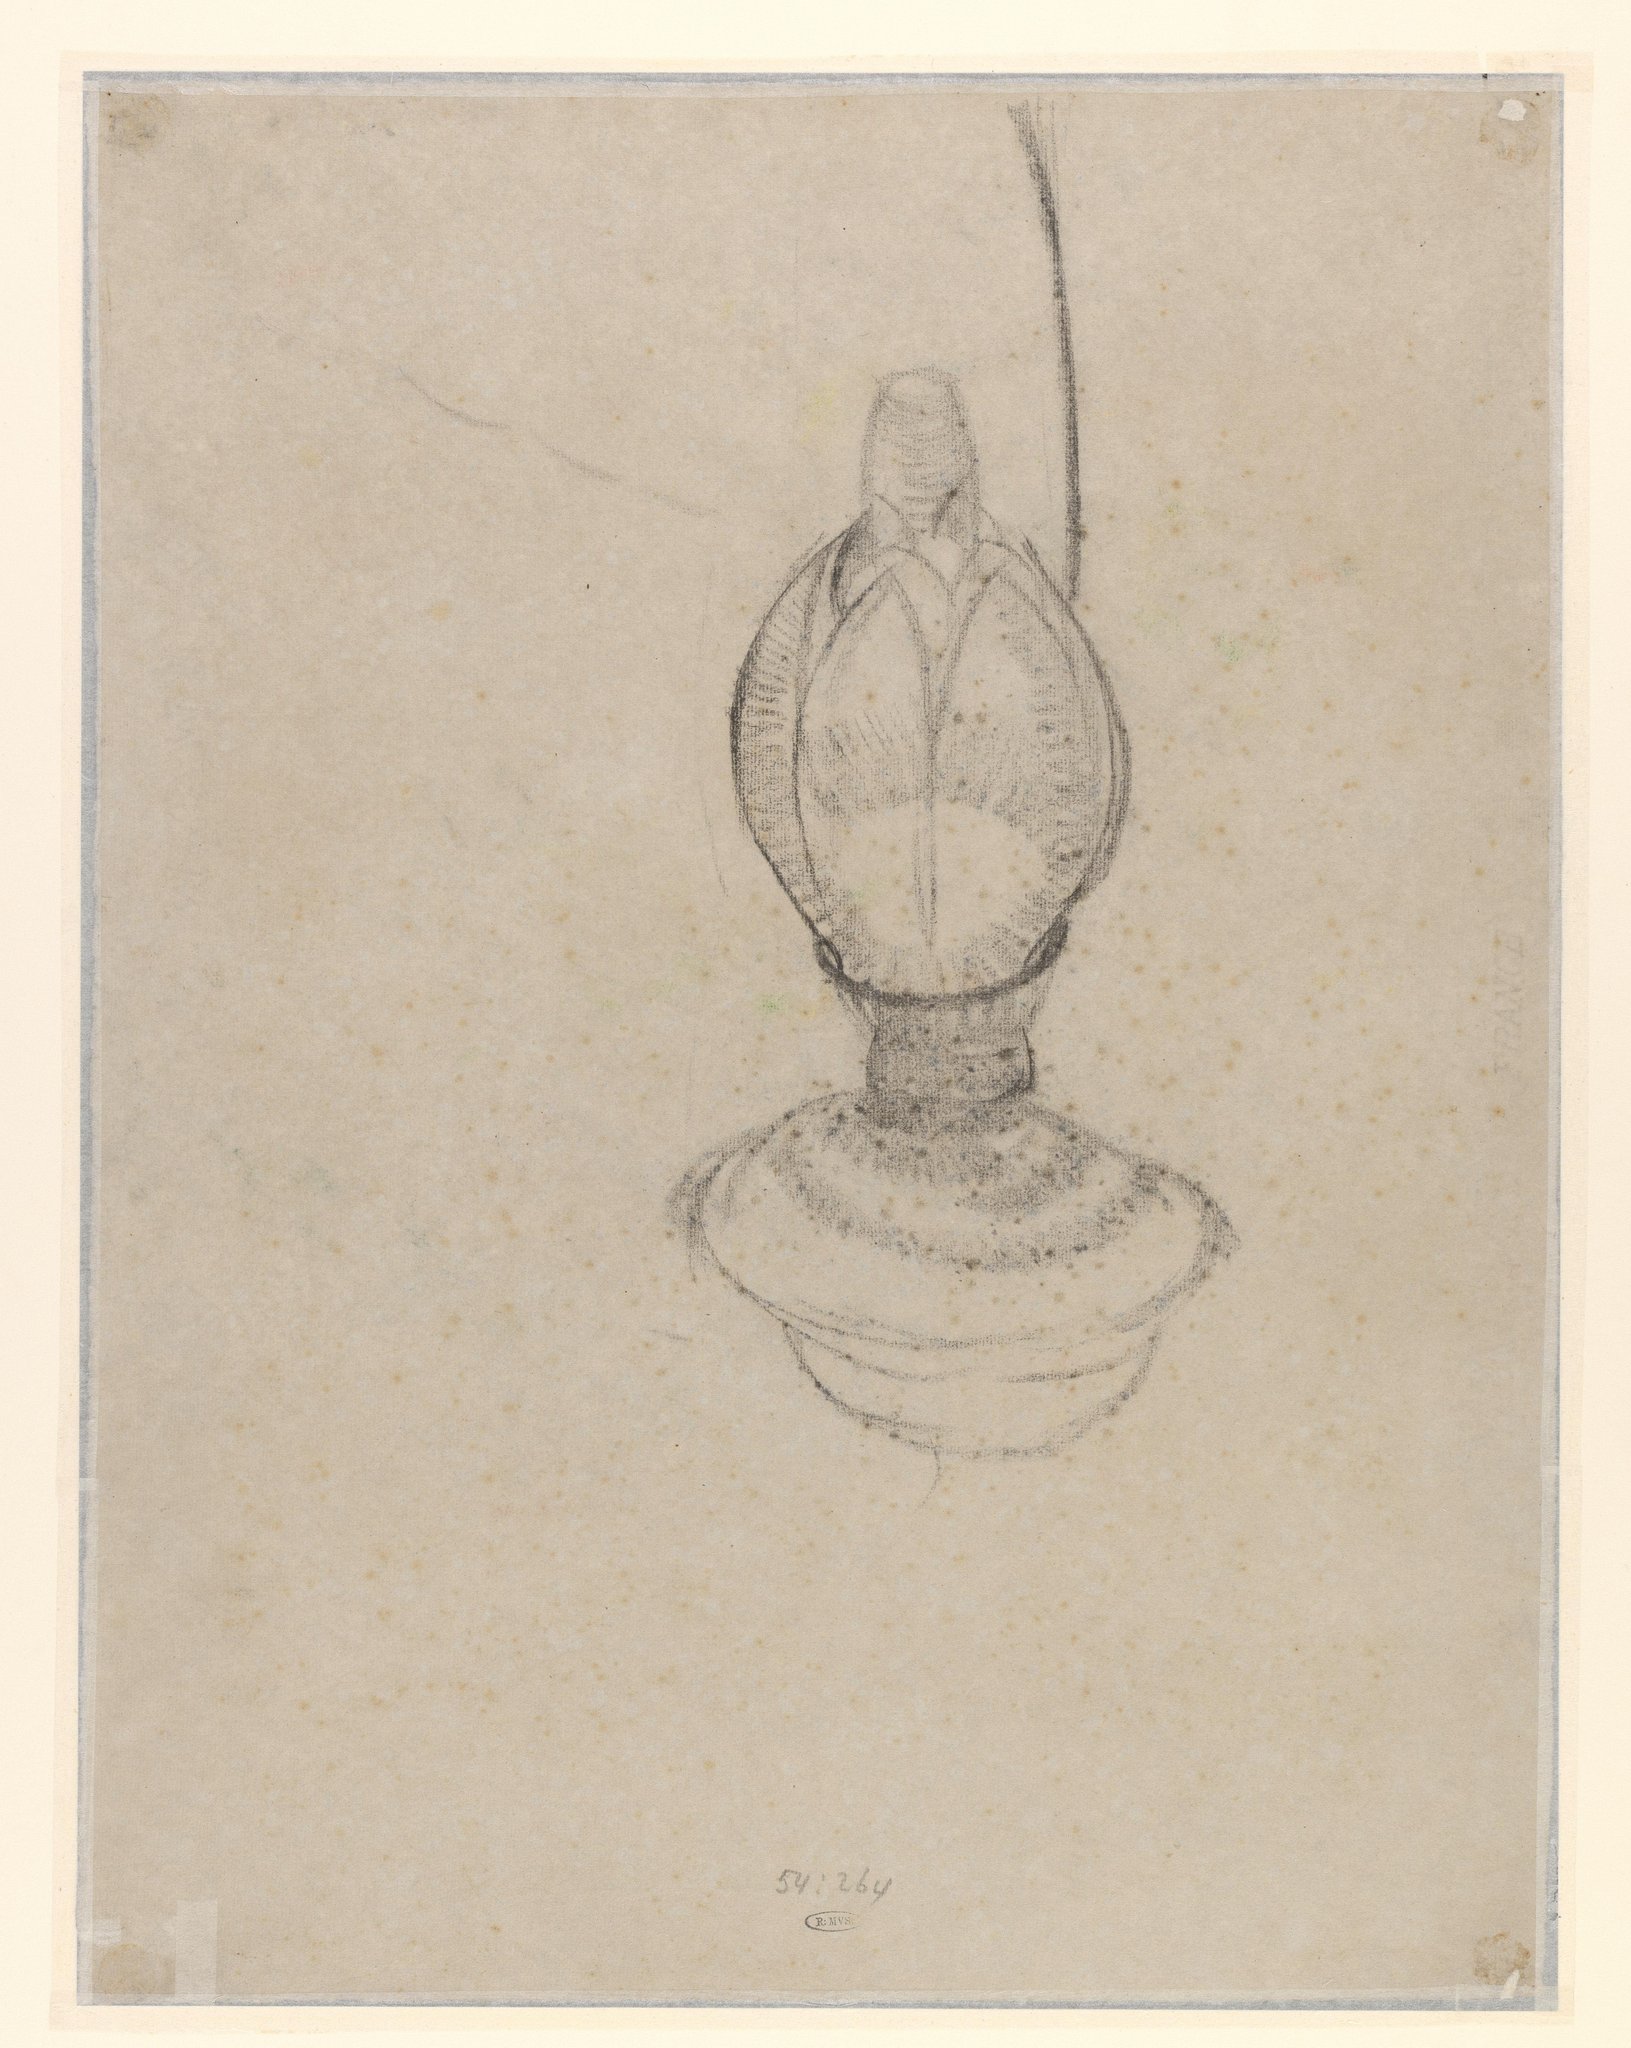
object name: drawing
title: Olielamp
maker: jo bezaan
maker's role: draughtsman, print maker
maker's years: 1894-1952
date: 1906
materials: charcoal, paper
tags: oil-lamp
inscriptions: date